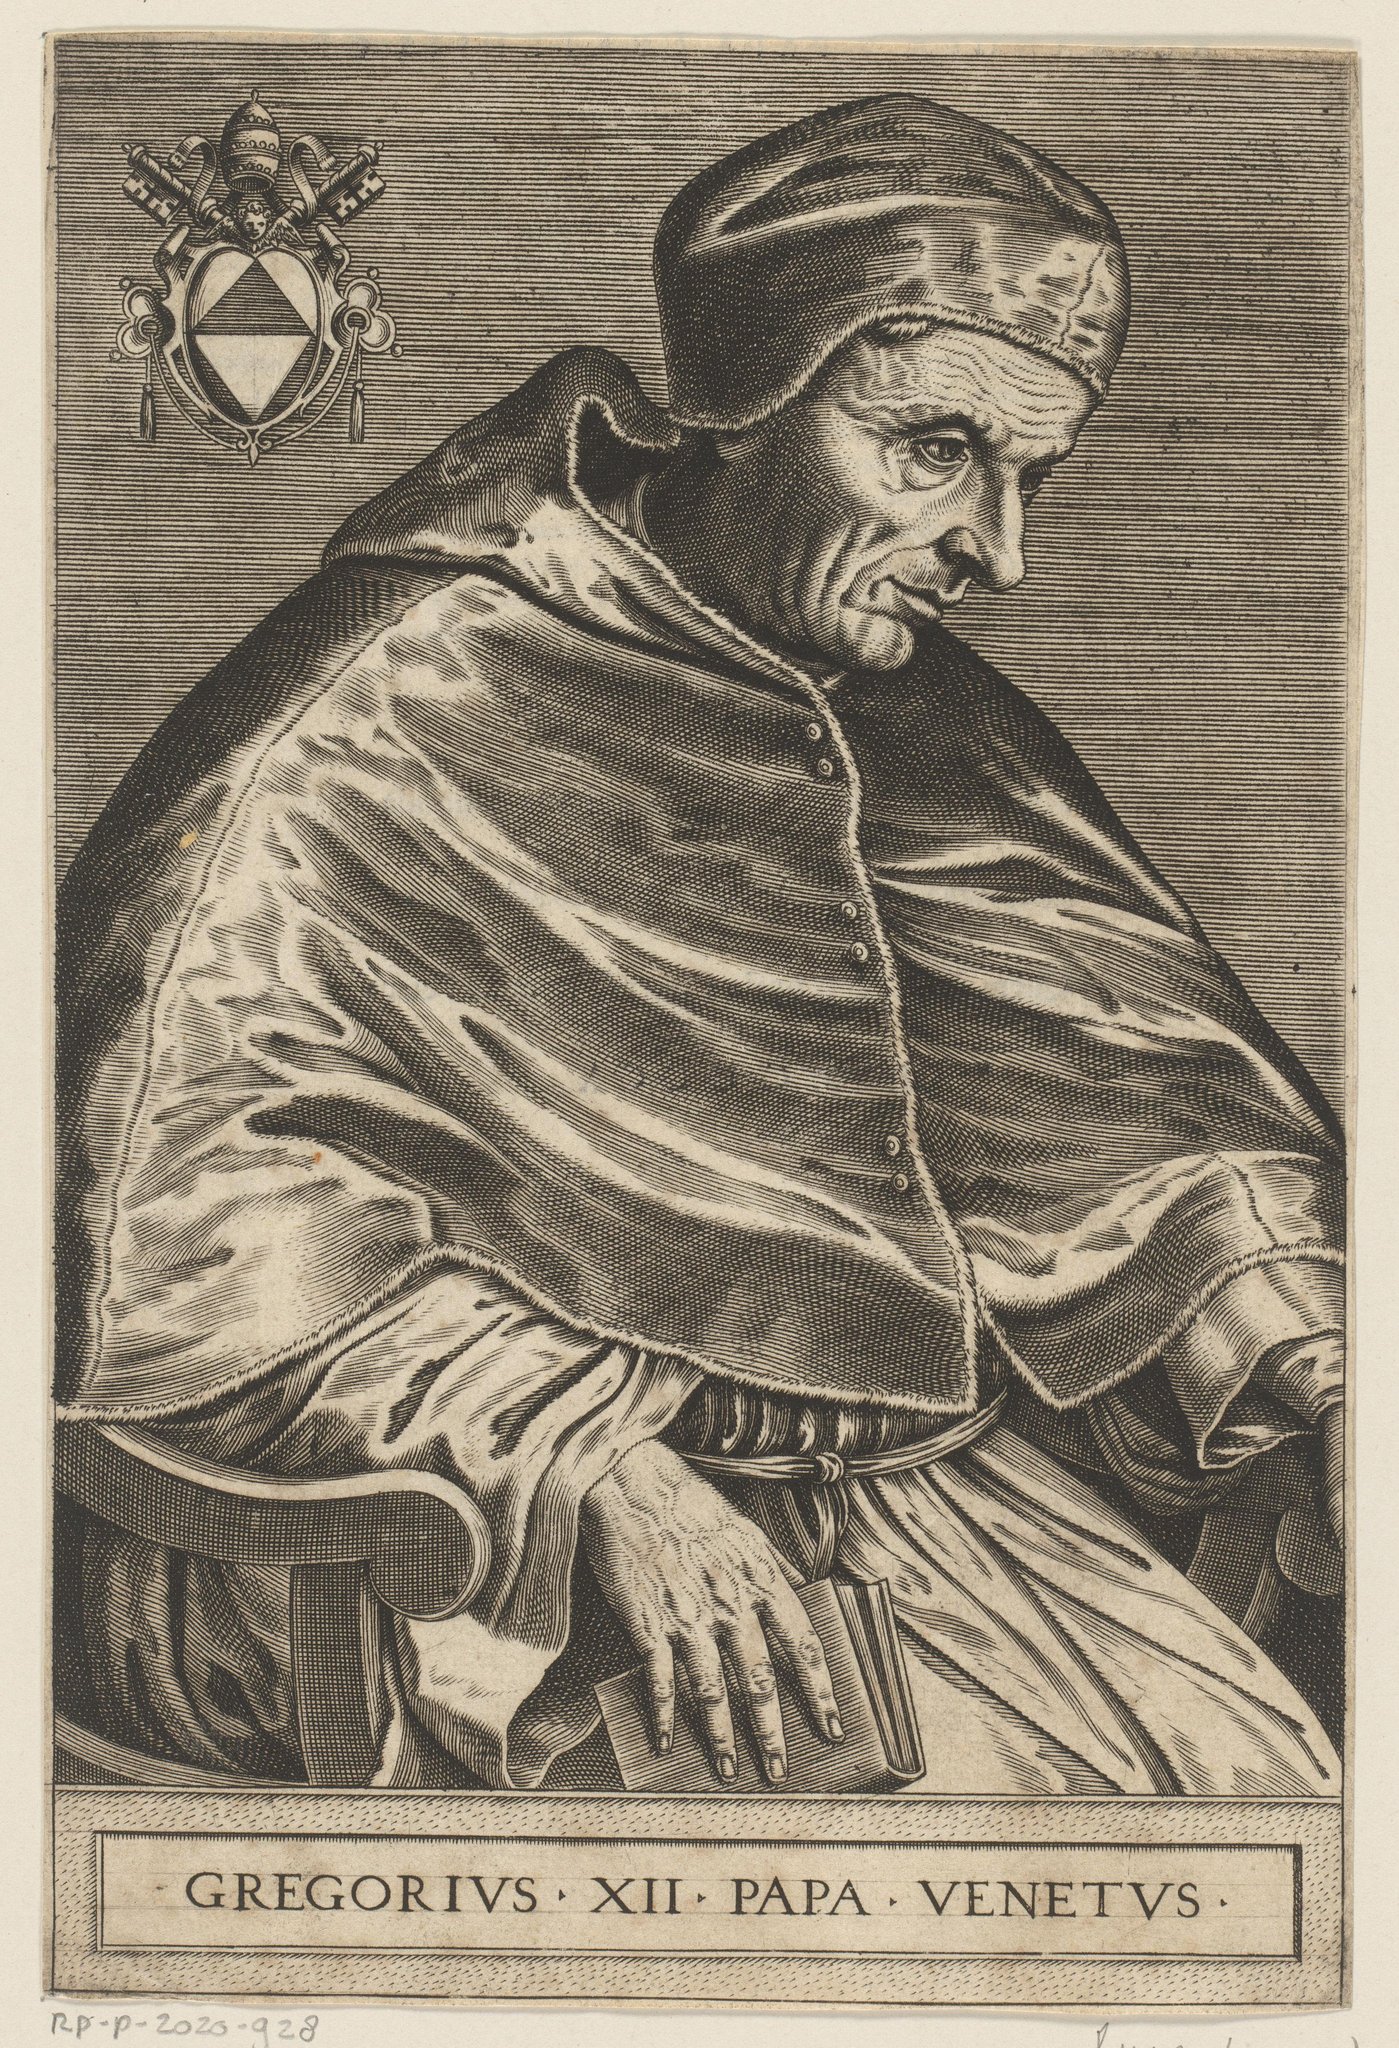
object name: print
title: Portret van paus Gregorius XII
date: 1568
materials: paper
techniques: engraving, letterpress printing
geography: rome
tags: clergyman, historical persons, pope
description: Prent uit: Panvinio, Onofrio. 27 pontificum maximorum elogia et imagines accuratissime ad uiuum aeneis typeis delineatae. Rome: Antonio Lafreri, 1568.